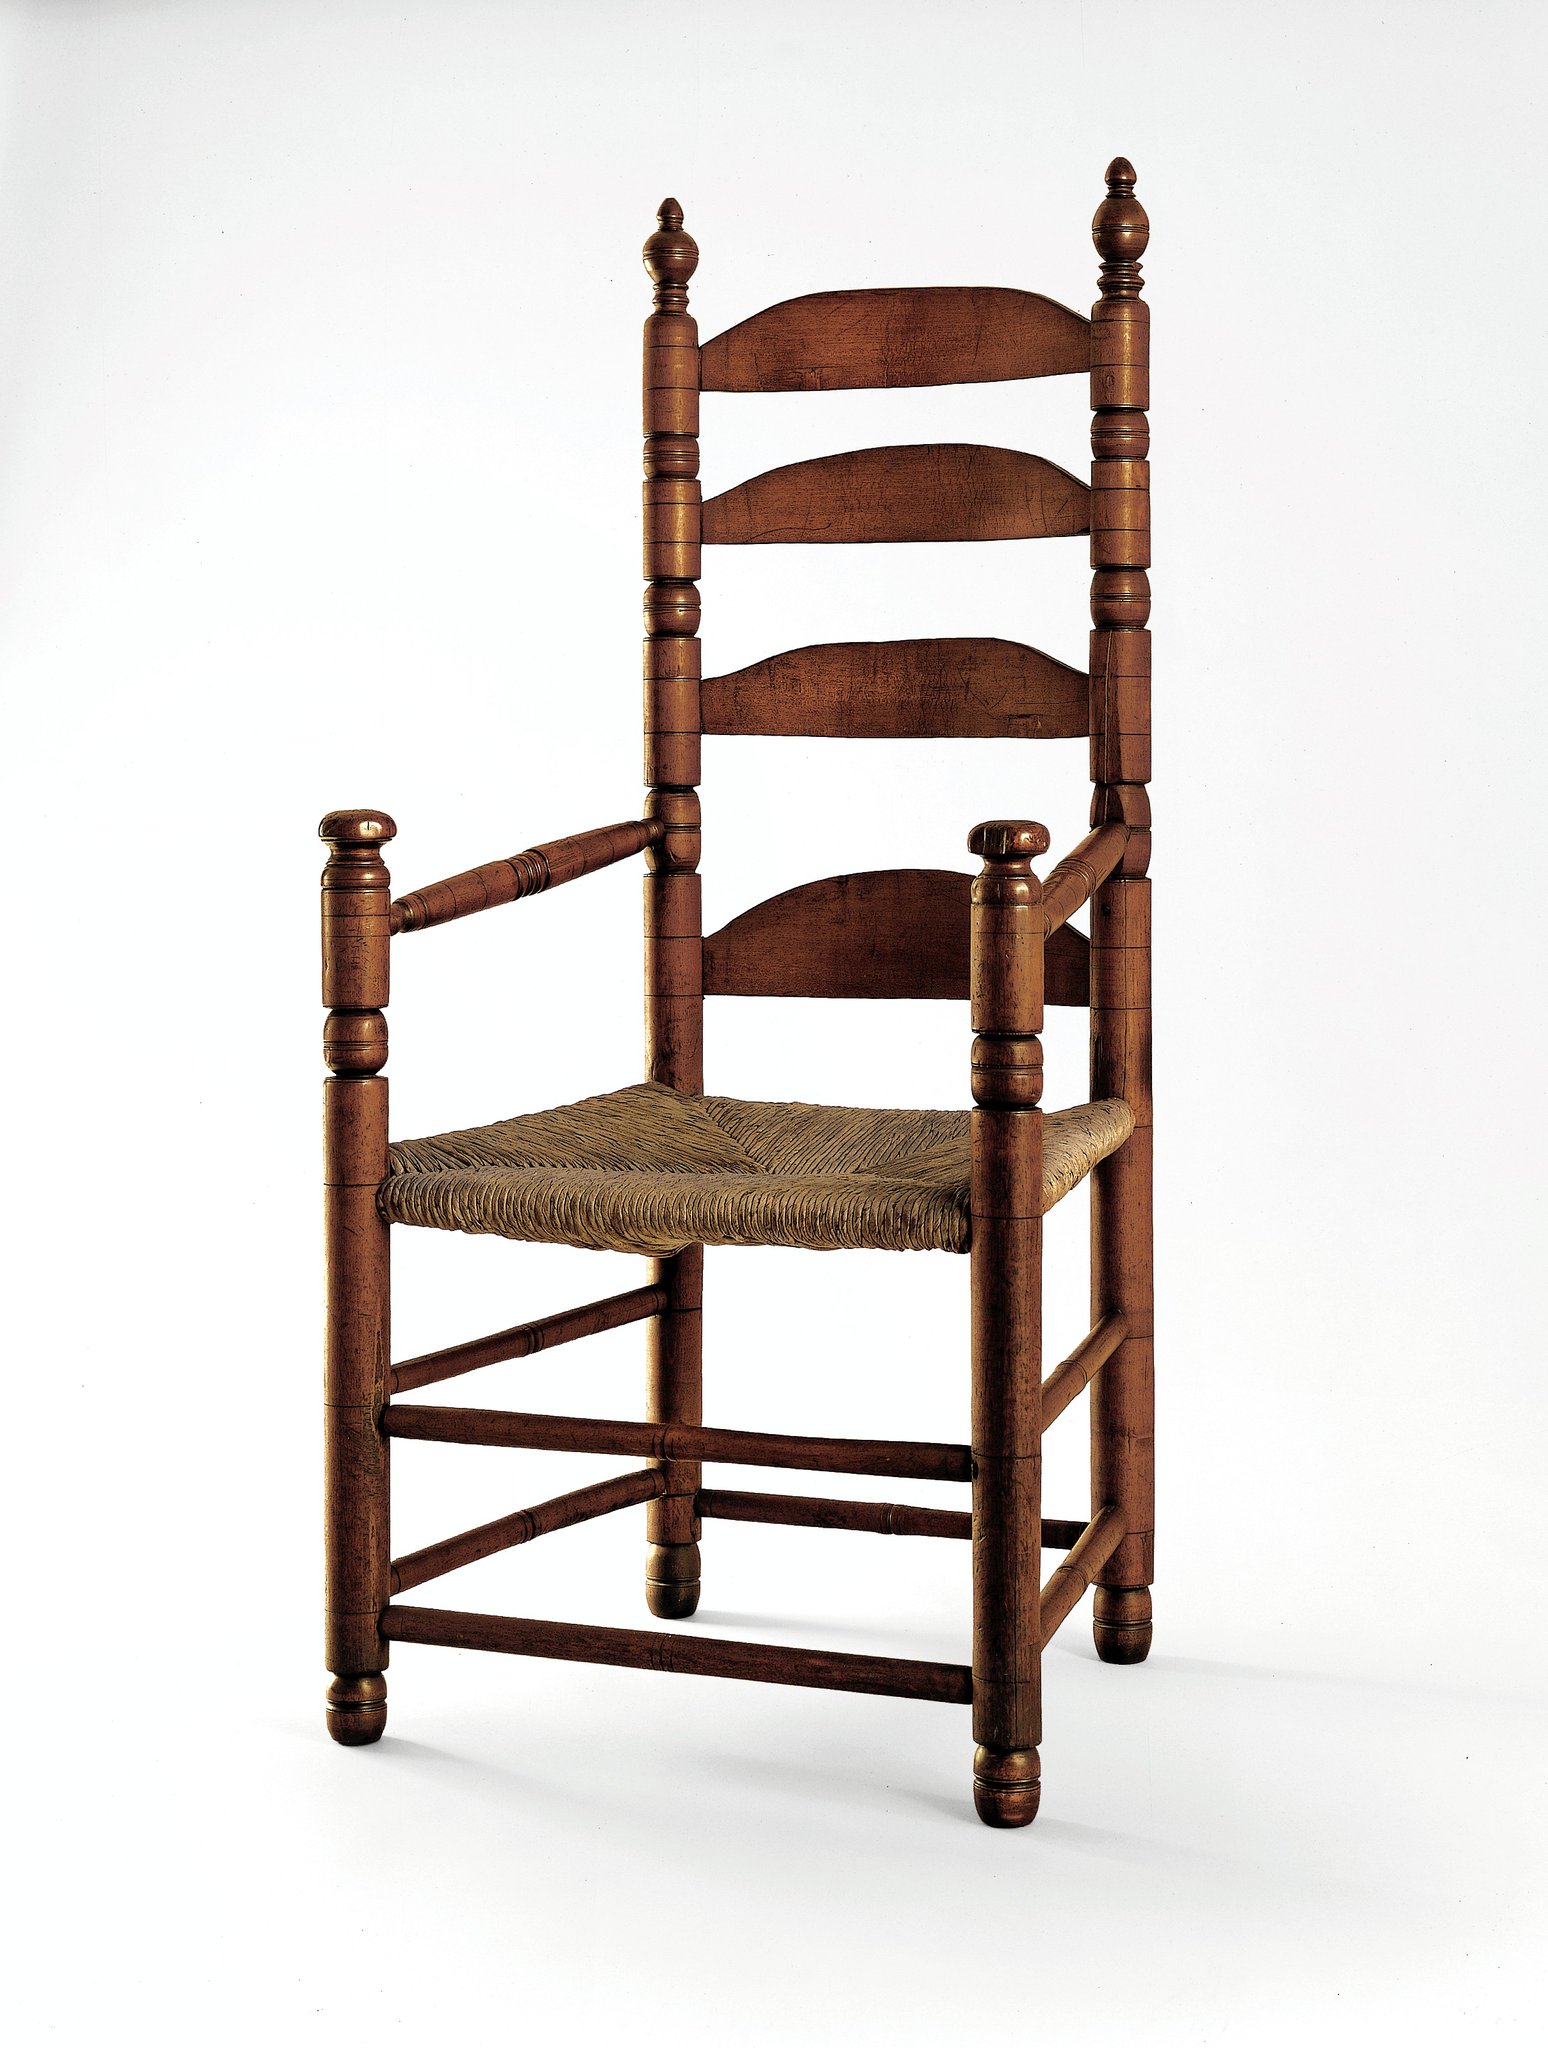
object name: armchair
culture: american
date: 1675-1700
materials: wood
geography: united states